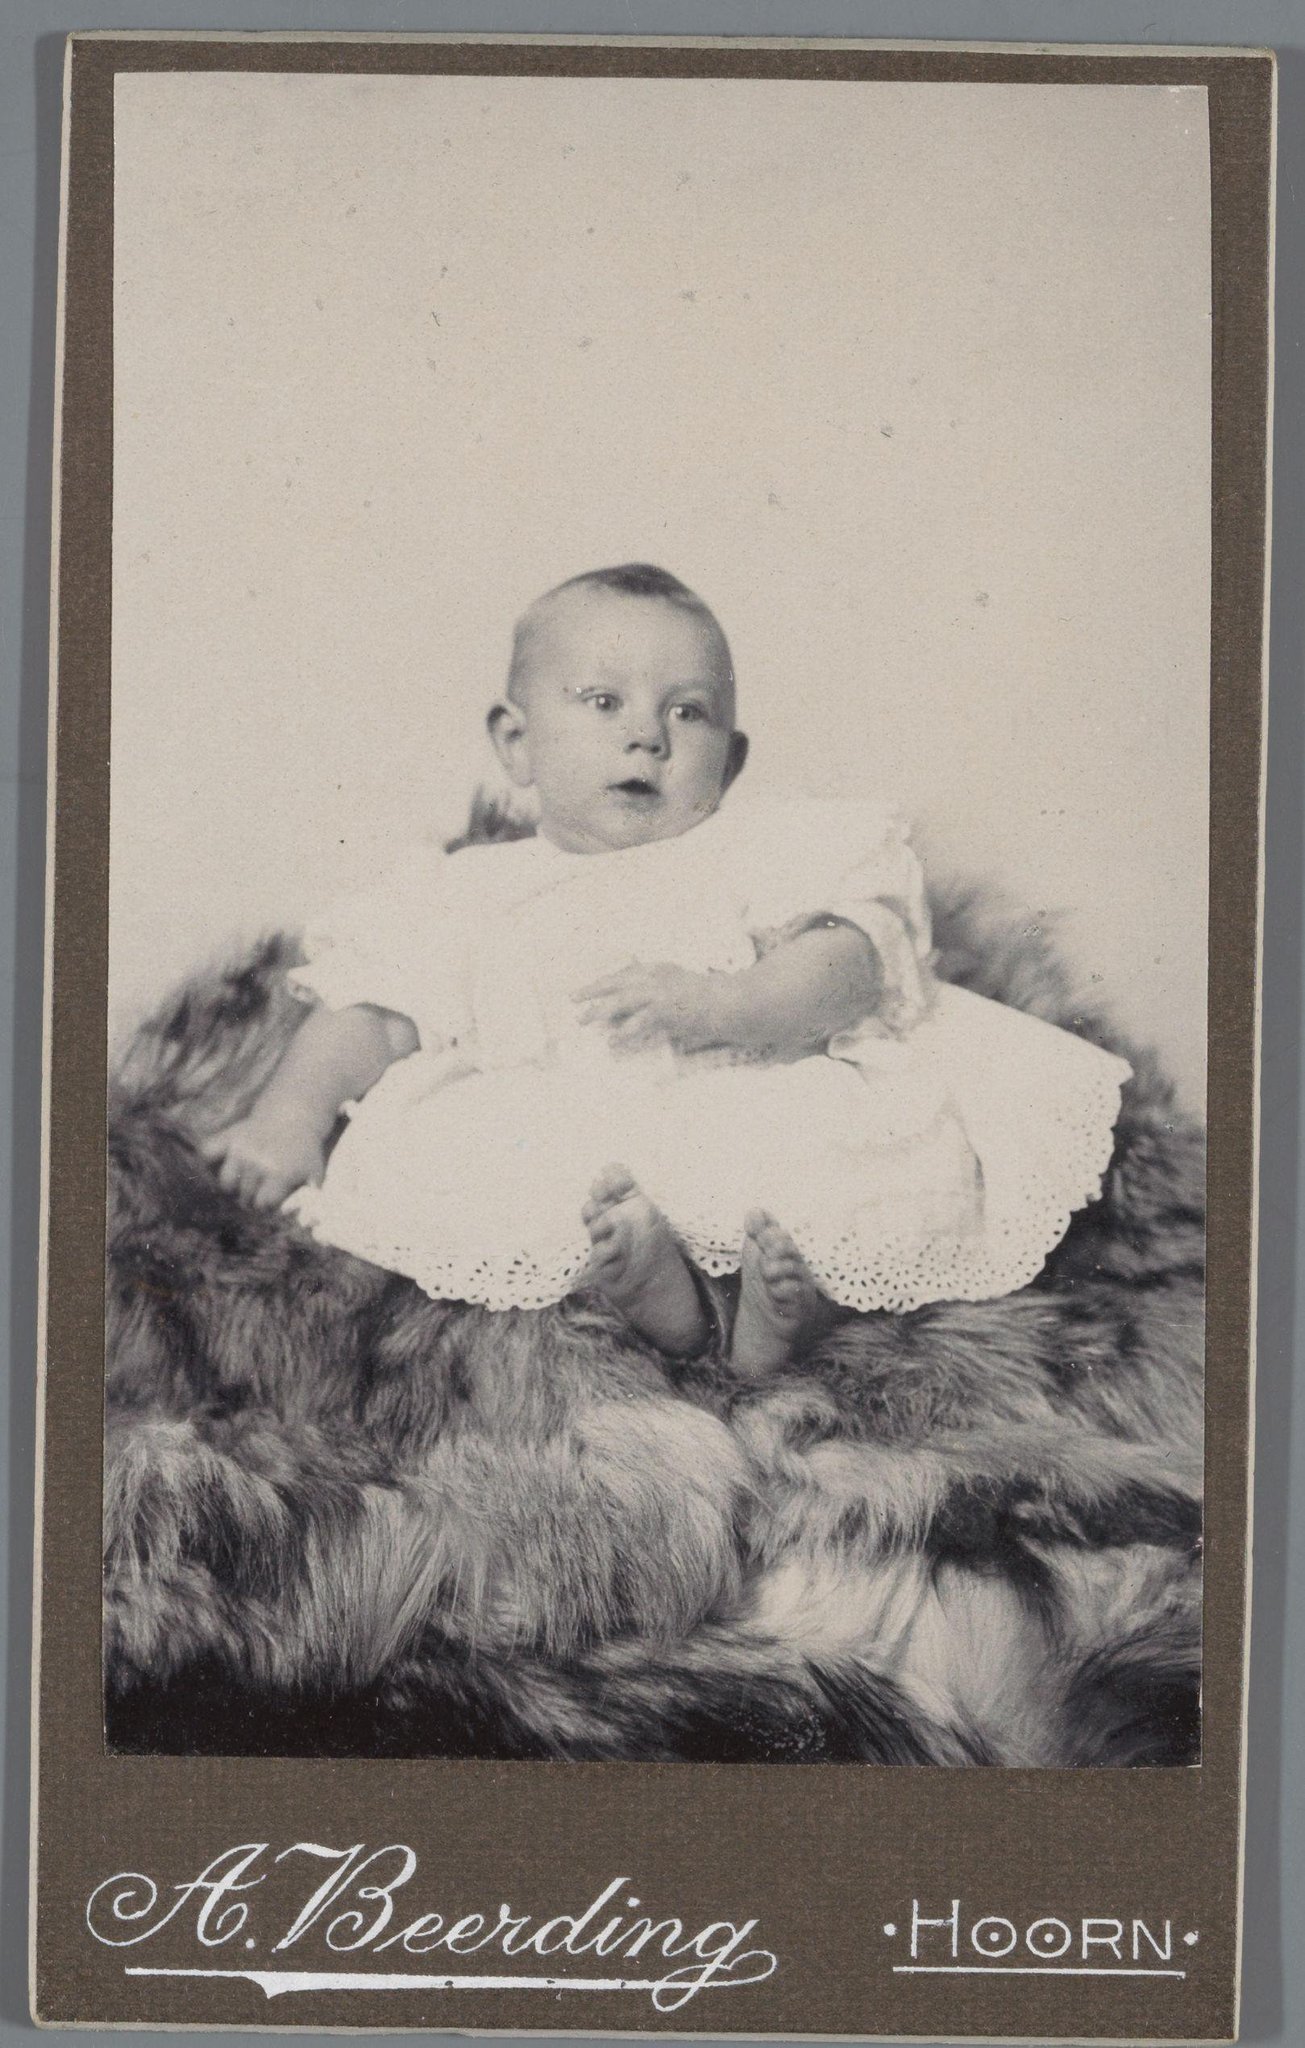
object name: photograph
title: Portret van Pieter Haan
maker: alida beerding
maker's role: fotograaf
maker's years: 1875-1949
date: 1910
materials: paper, cardboard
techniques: collodion silver print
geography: hoorn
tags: historical persons, infant, baby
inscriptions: inscription: ‘Pieter Haan/ 20.3.1909’